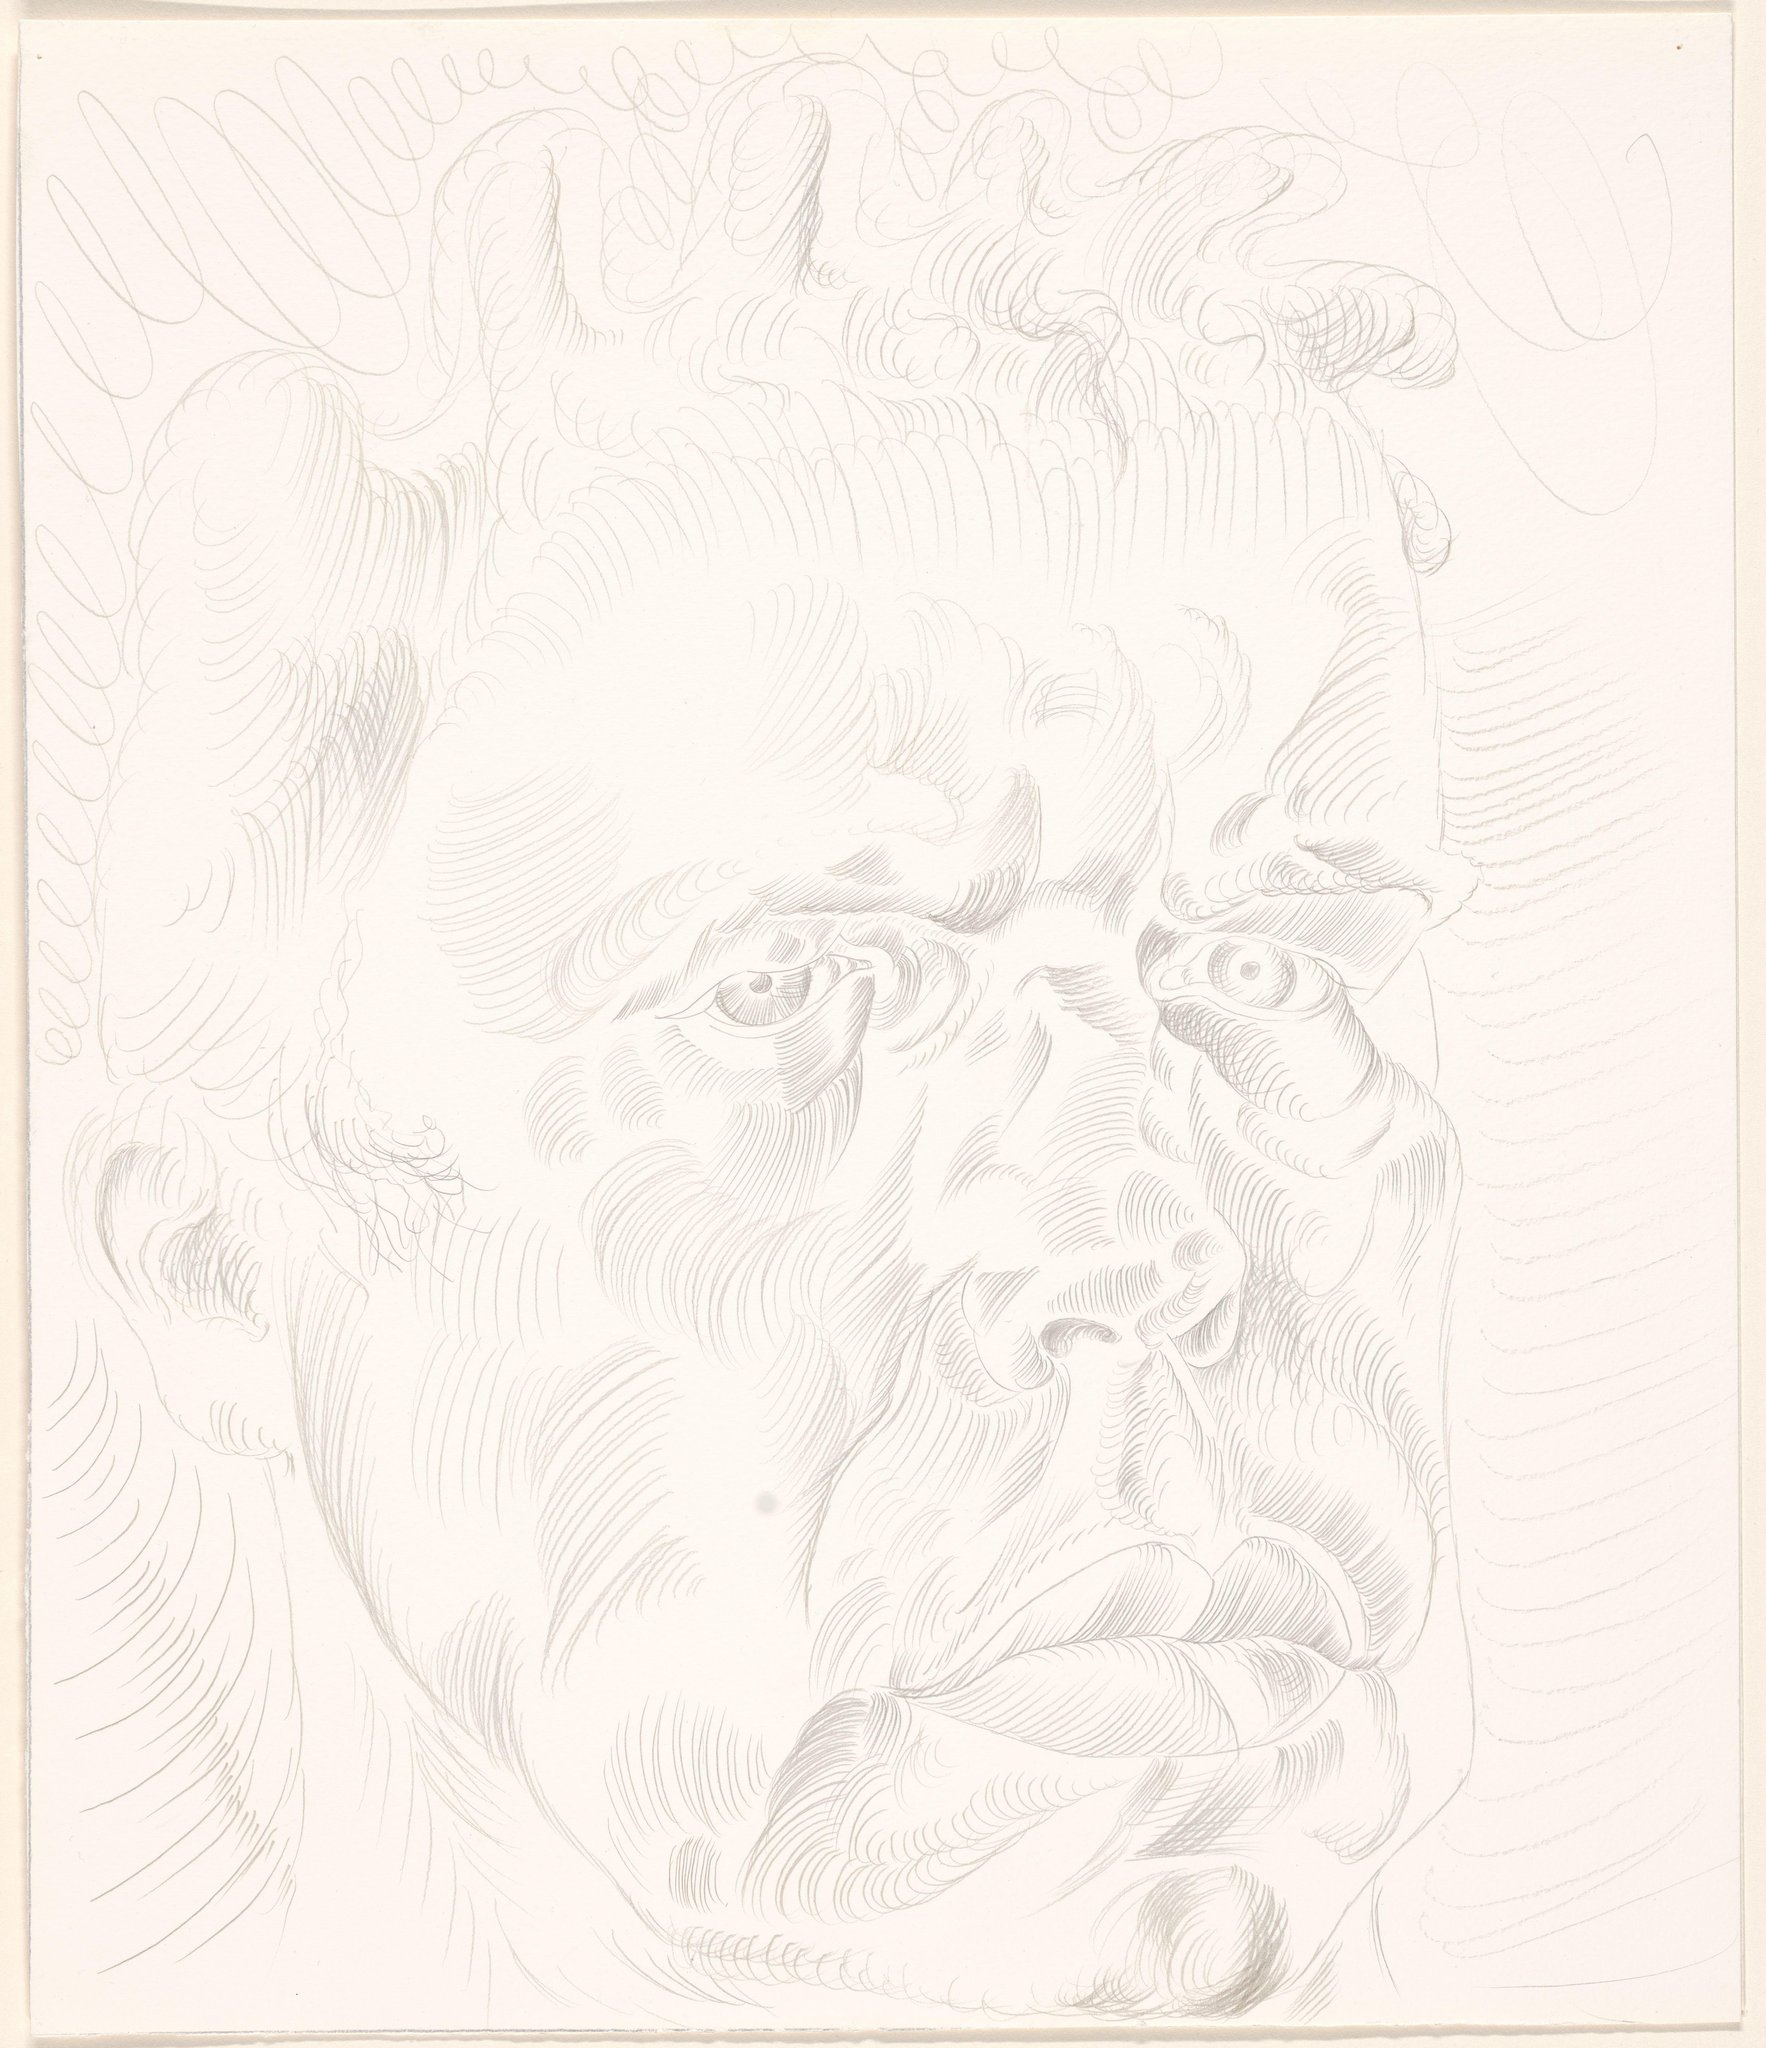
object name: drawing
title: Zelfportret 2003 nr. 83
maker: philip akkerman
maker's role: draughtsman, painter, sculptor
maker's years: 1957-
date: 2003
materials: paper, pencil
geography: netherlands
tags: painter, draughtsman, sculptor, philip akkerman, historical persons, portrait, self-portrait of painter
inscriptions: collector's mark: Lugt 2228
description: ¾ En face weergegeven ingezoomd licht gedeformeerd zelfportret met kort in plukken opstaand fantasie haar.